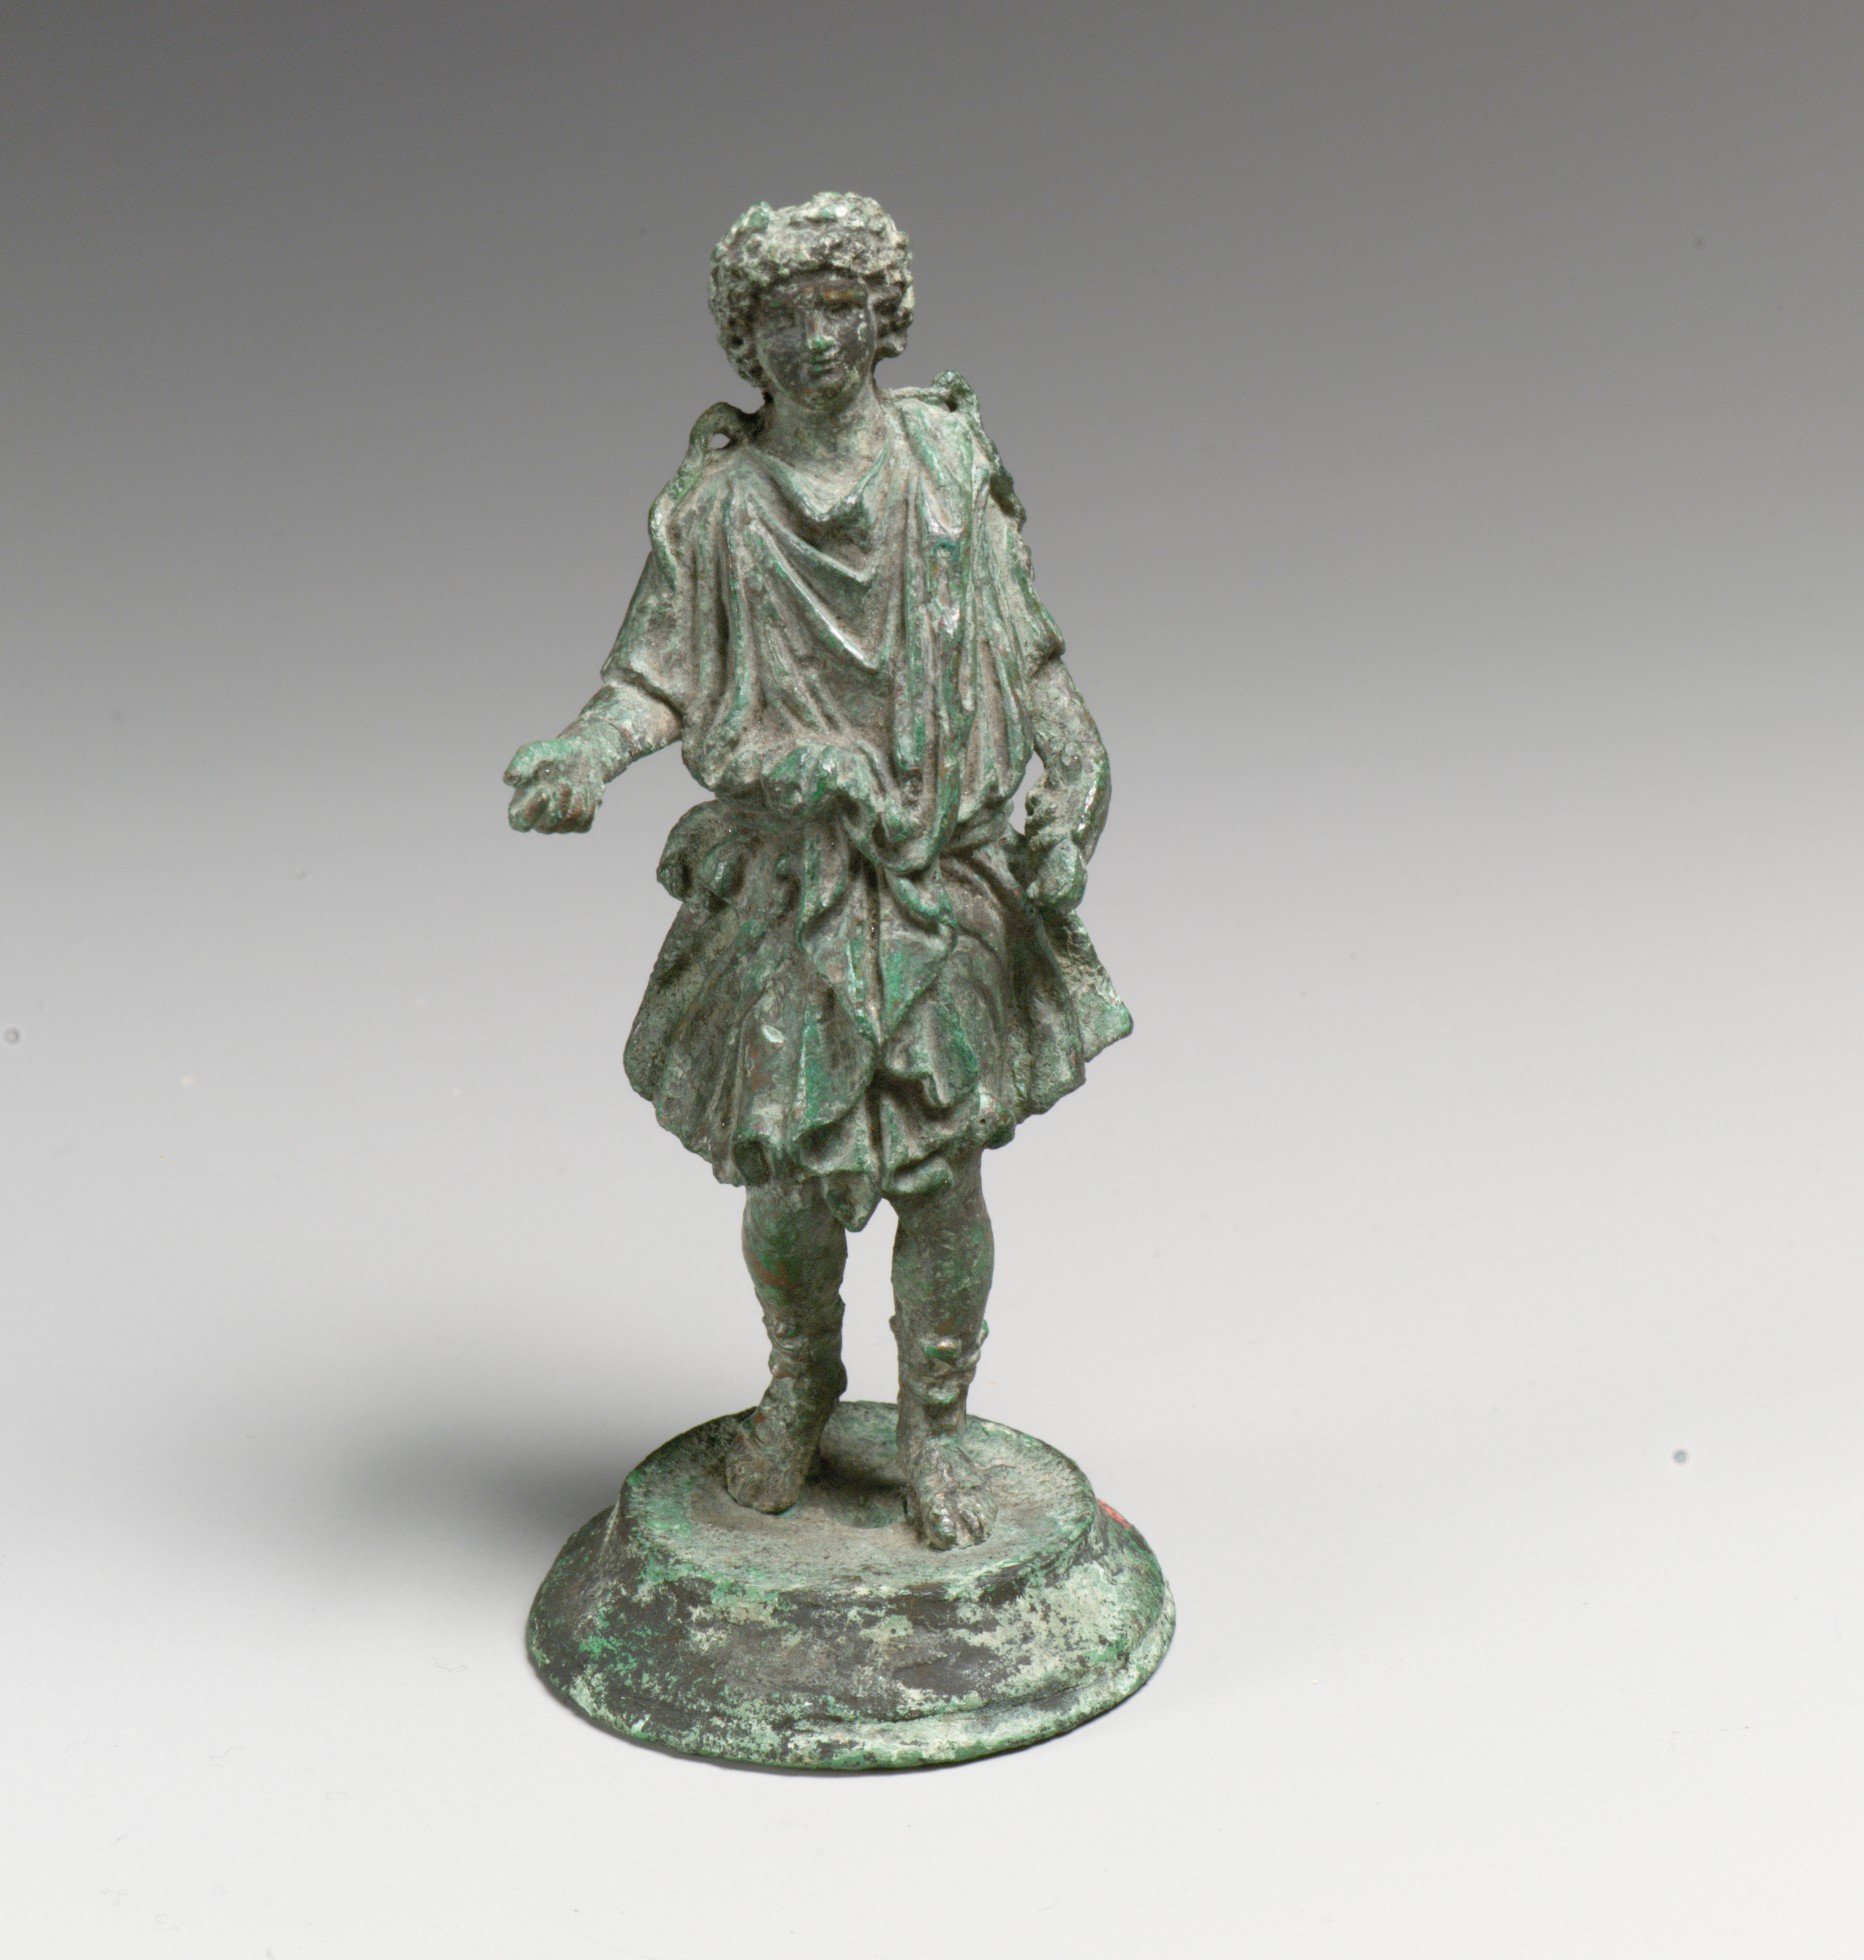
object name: statuette of a lar dancing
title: Bronze statuette of a Lar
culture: roman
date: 1-200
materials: bronze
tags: men